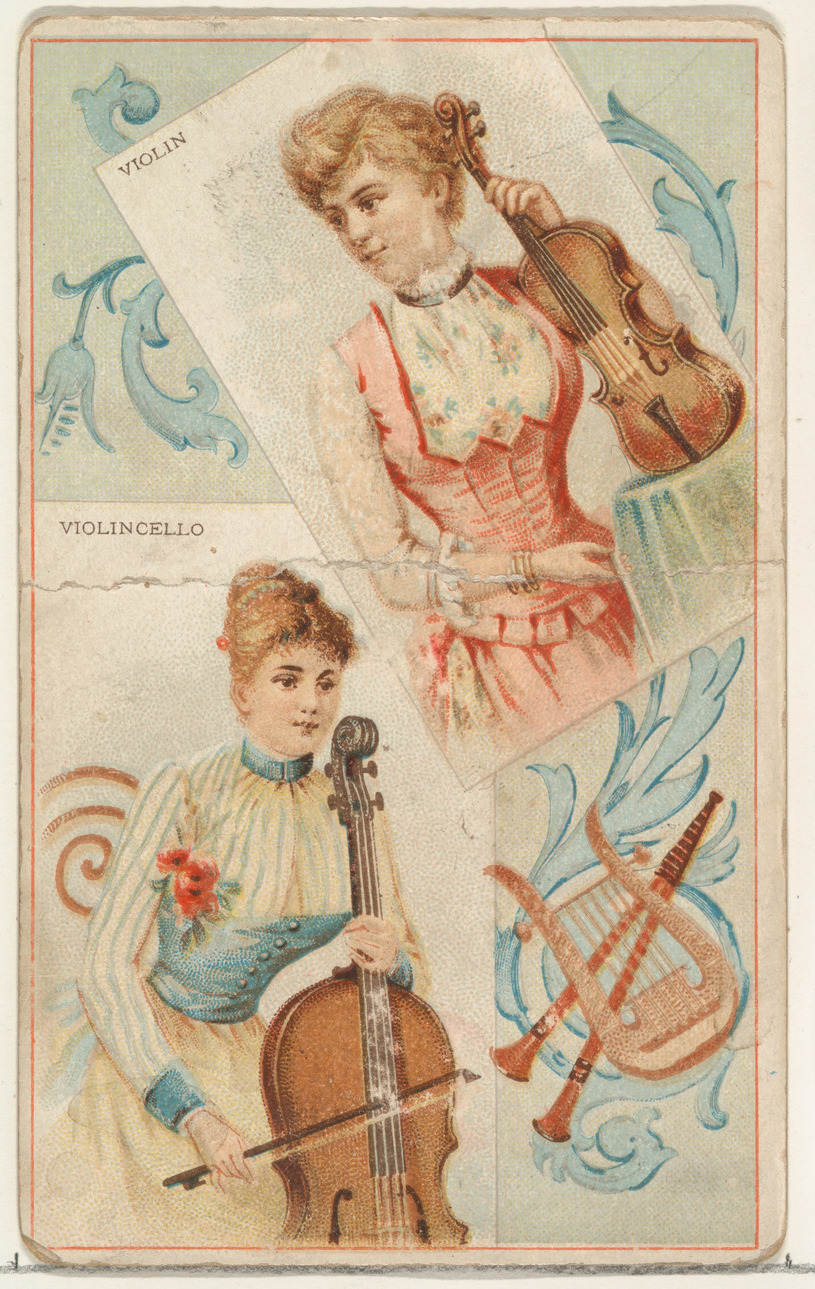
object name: print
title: Violin and Violincello, from the Musical Instruments series (N121) issued by Duke Sons & Co. to promote Honest Long Cut Tobacco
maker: w. duke, sons & co.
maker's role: publisher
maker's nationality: american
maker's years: 1870-1920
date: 1888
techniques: color lithograph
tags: women,violas